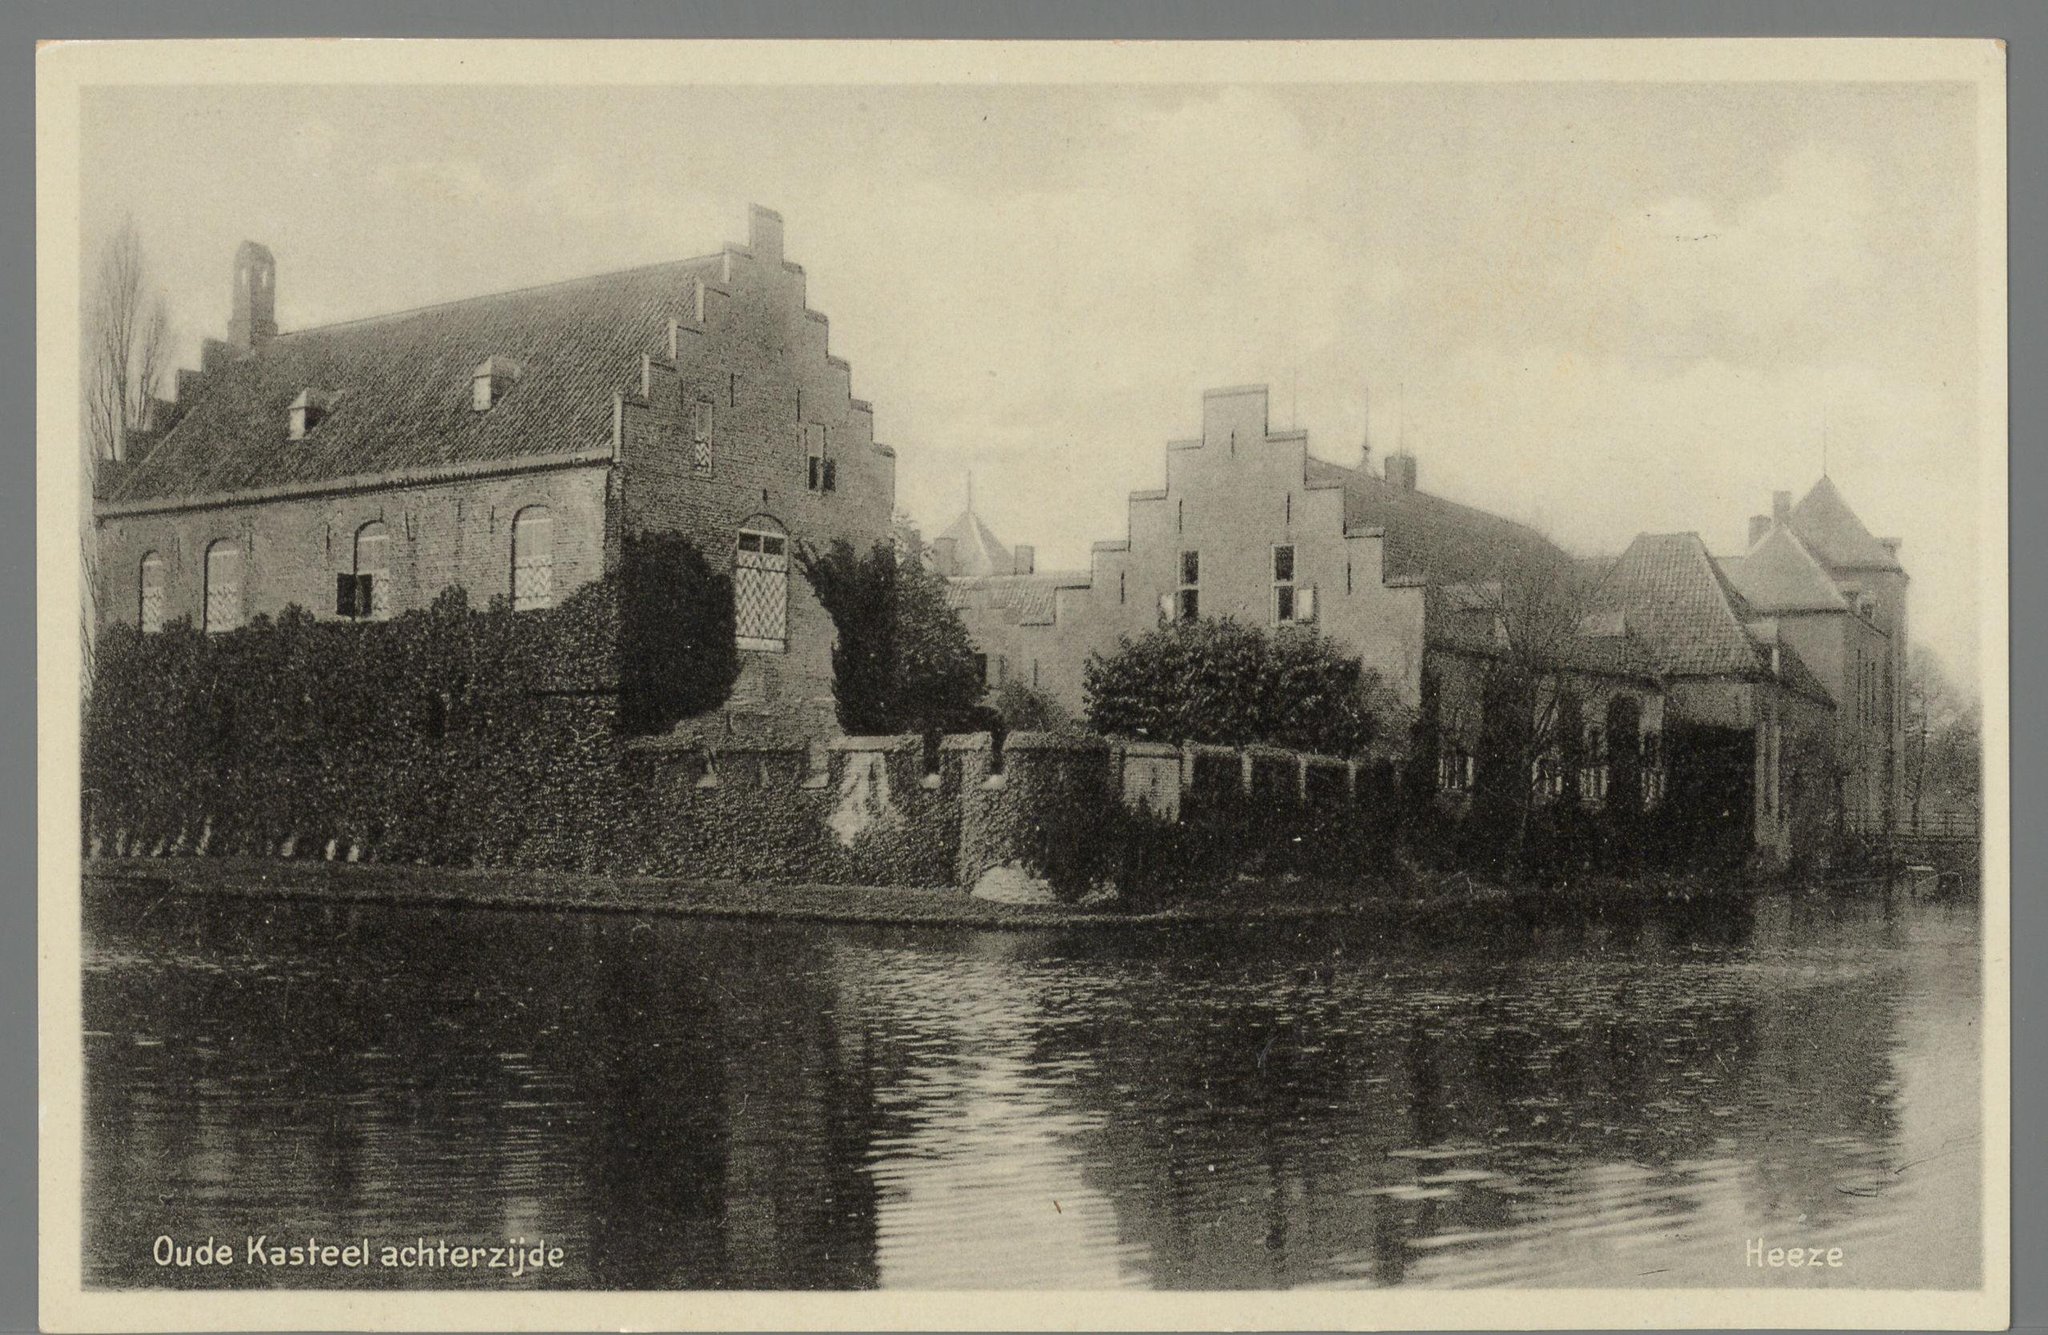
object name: photomechanical print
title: Oude Kasteel achterzijde. Heeze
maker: Anonymous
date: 1913-1948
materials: cardboard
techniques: photograph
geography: heeze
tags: castle, canal